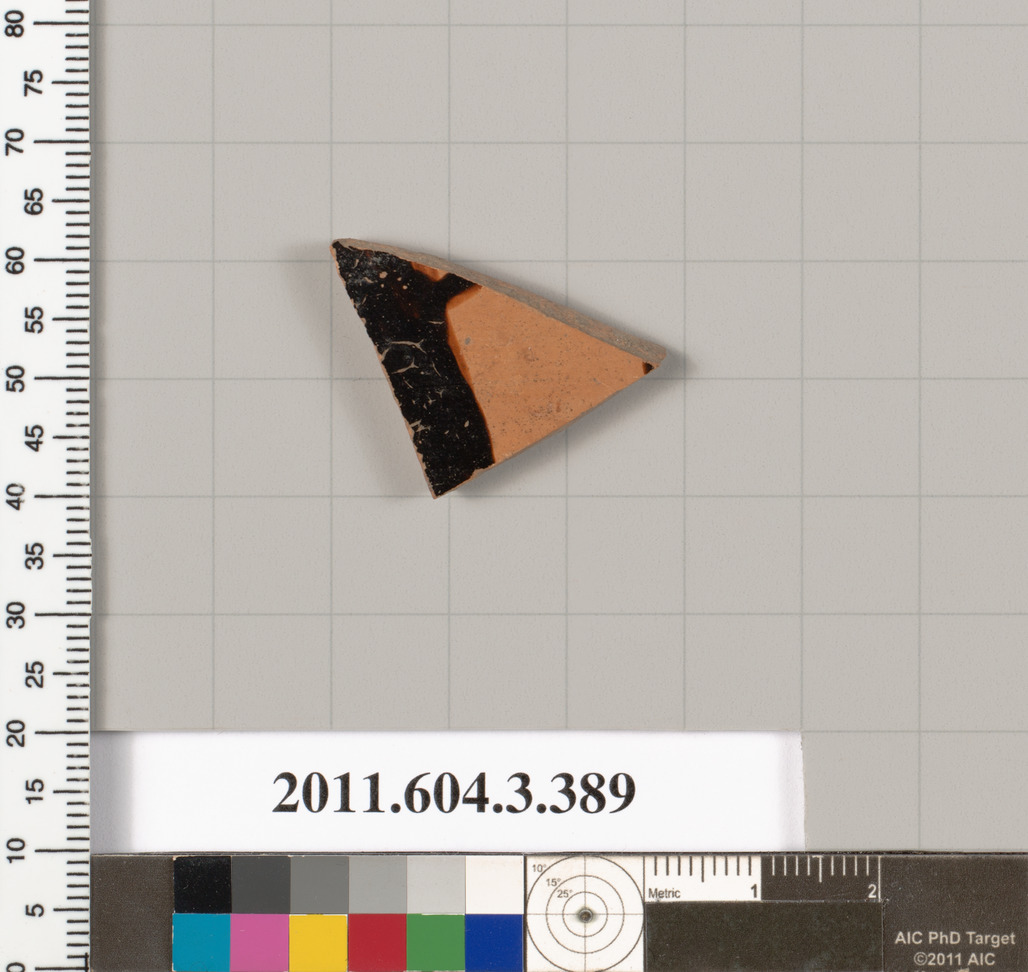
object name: neck amphora fragment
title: Terracotta fragment of a neck-amphora (jar)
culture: greek, attic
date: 525-501 BCE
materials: terracotta